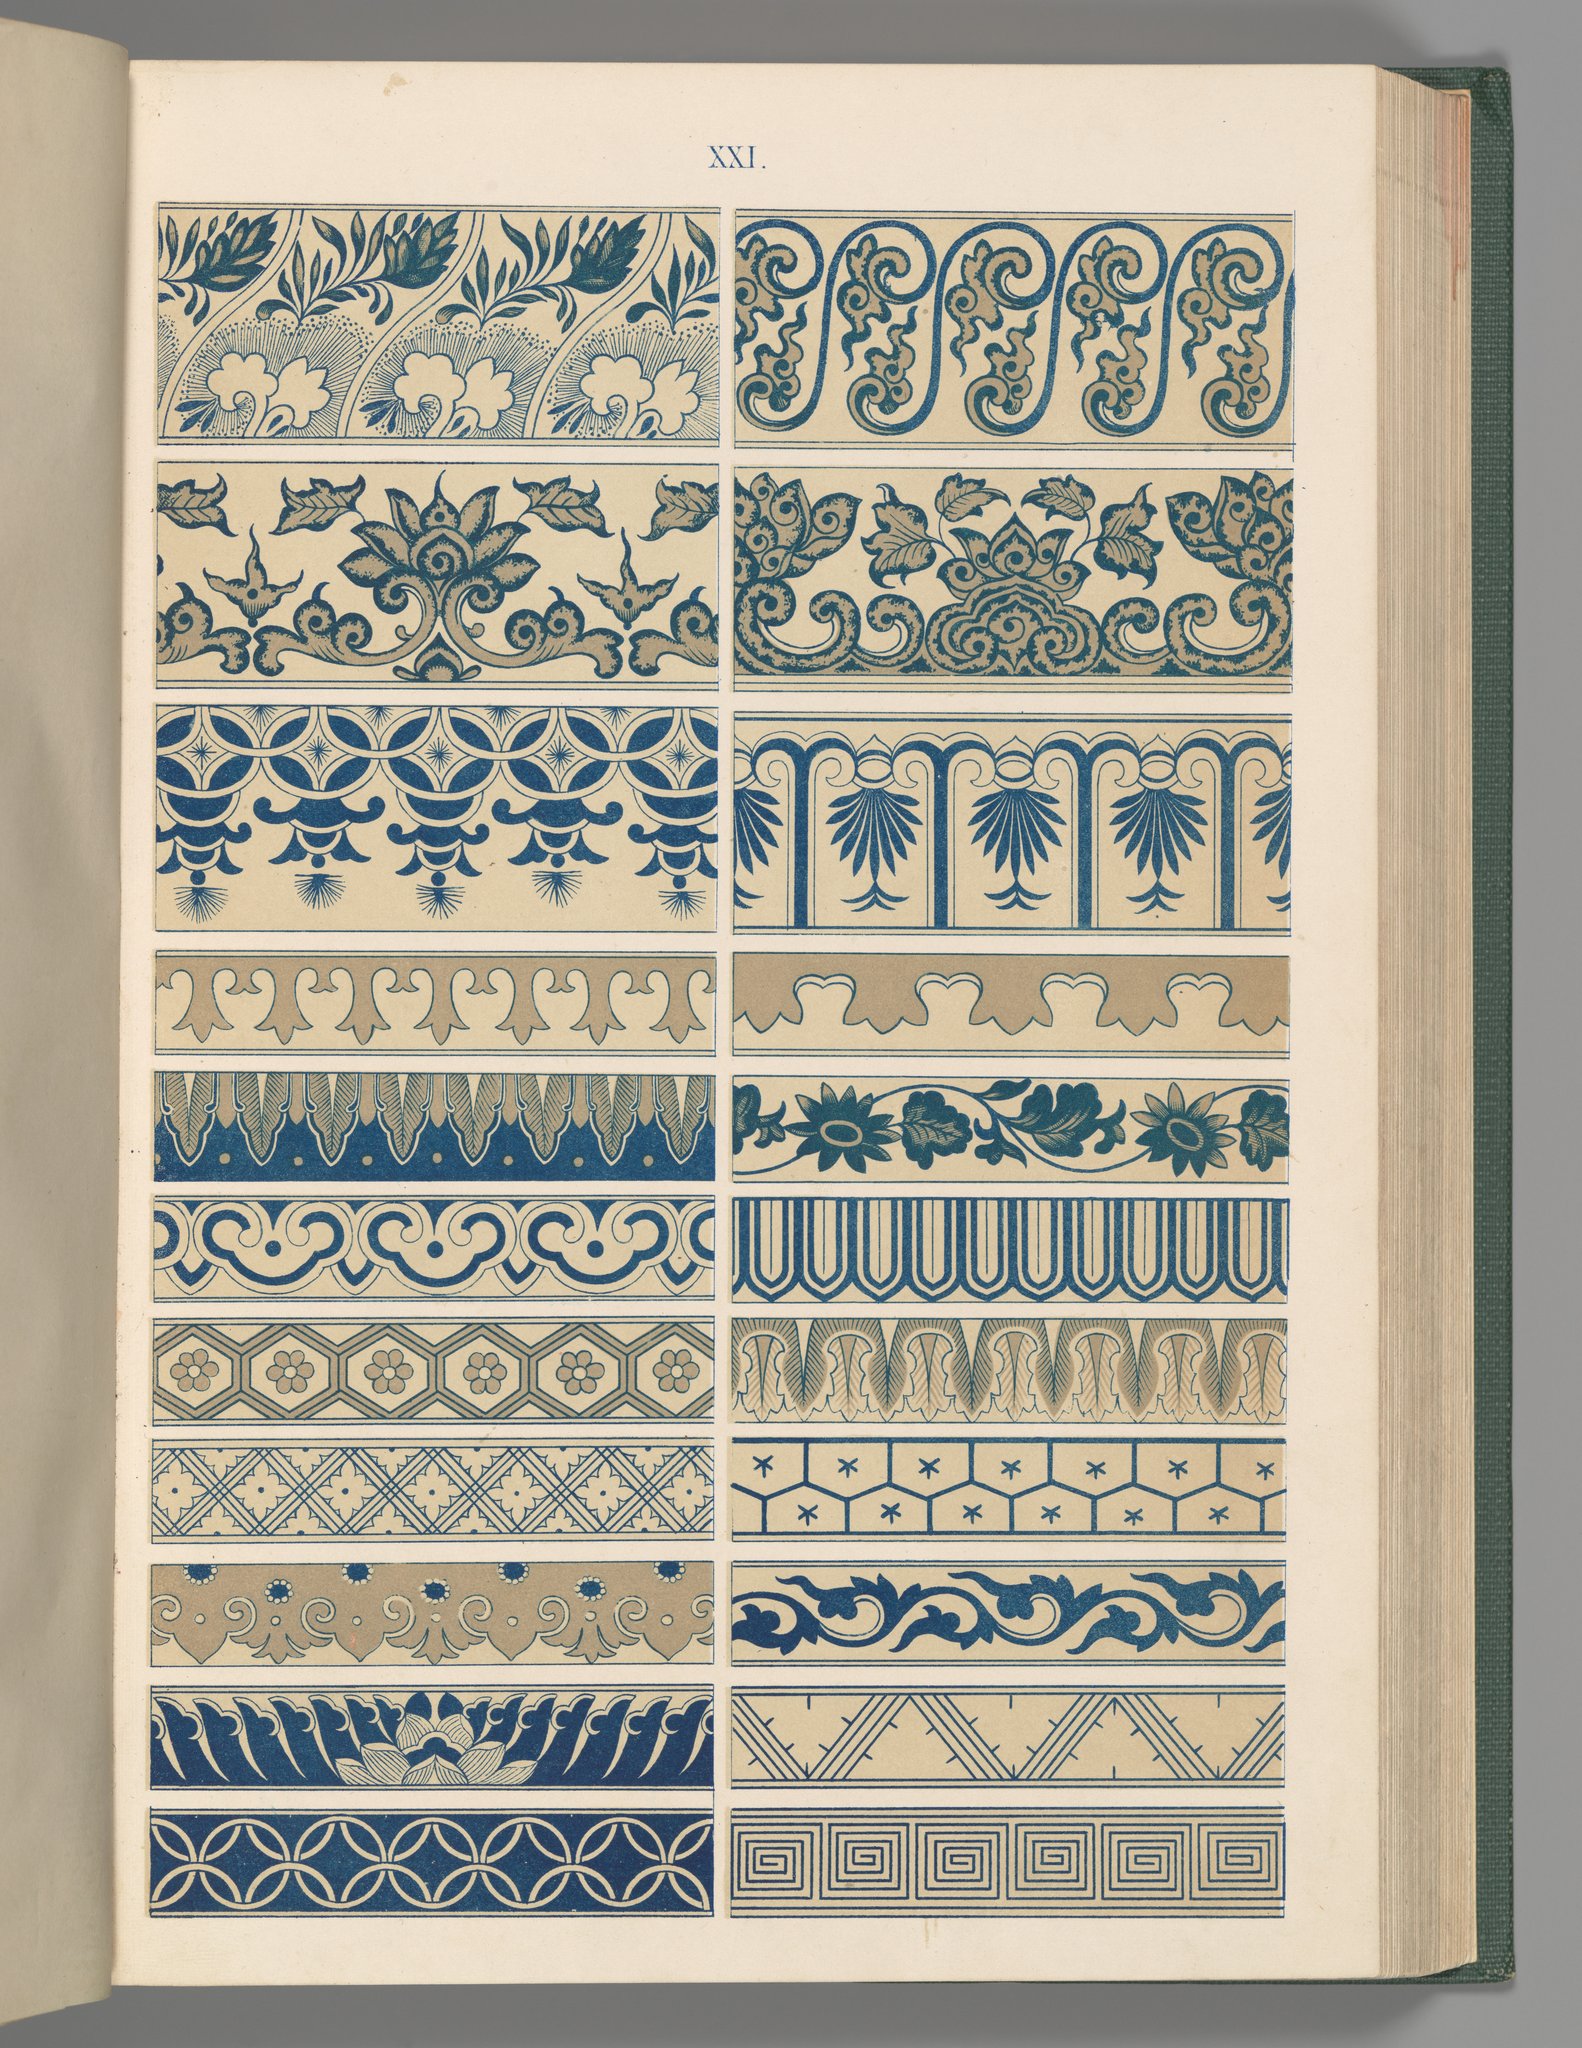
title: Examples of Chinese ornament selected from objects in the South Kensington Museum and other collections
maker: owen jones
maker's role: author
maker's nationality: british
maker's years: 1809-1874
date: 1867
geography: england